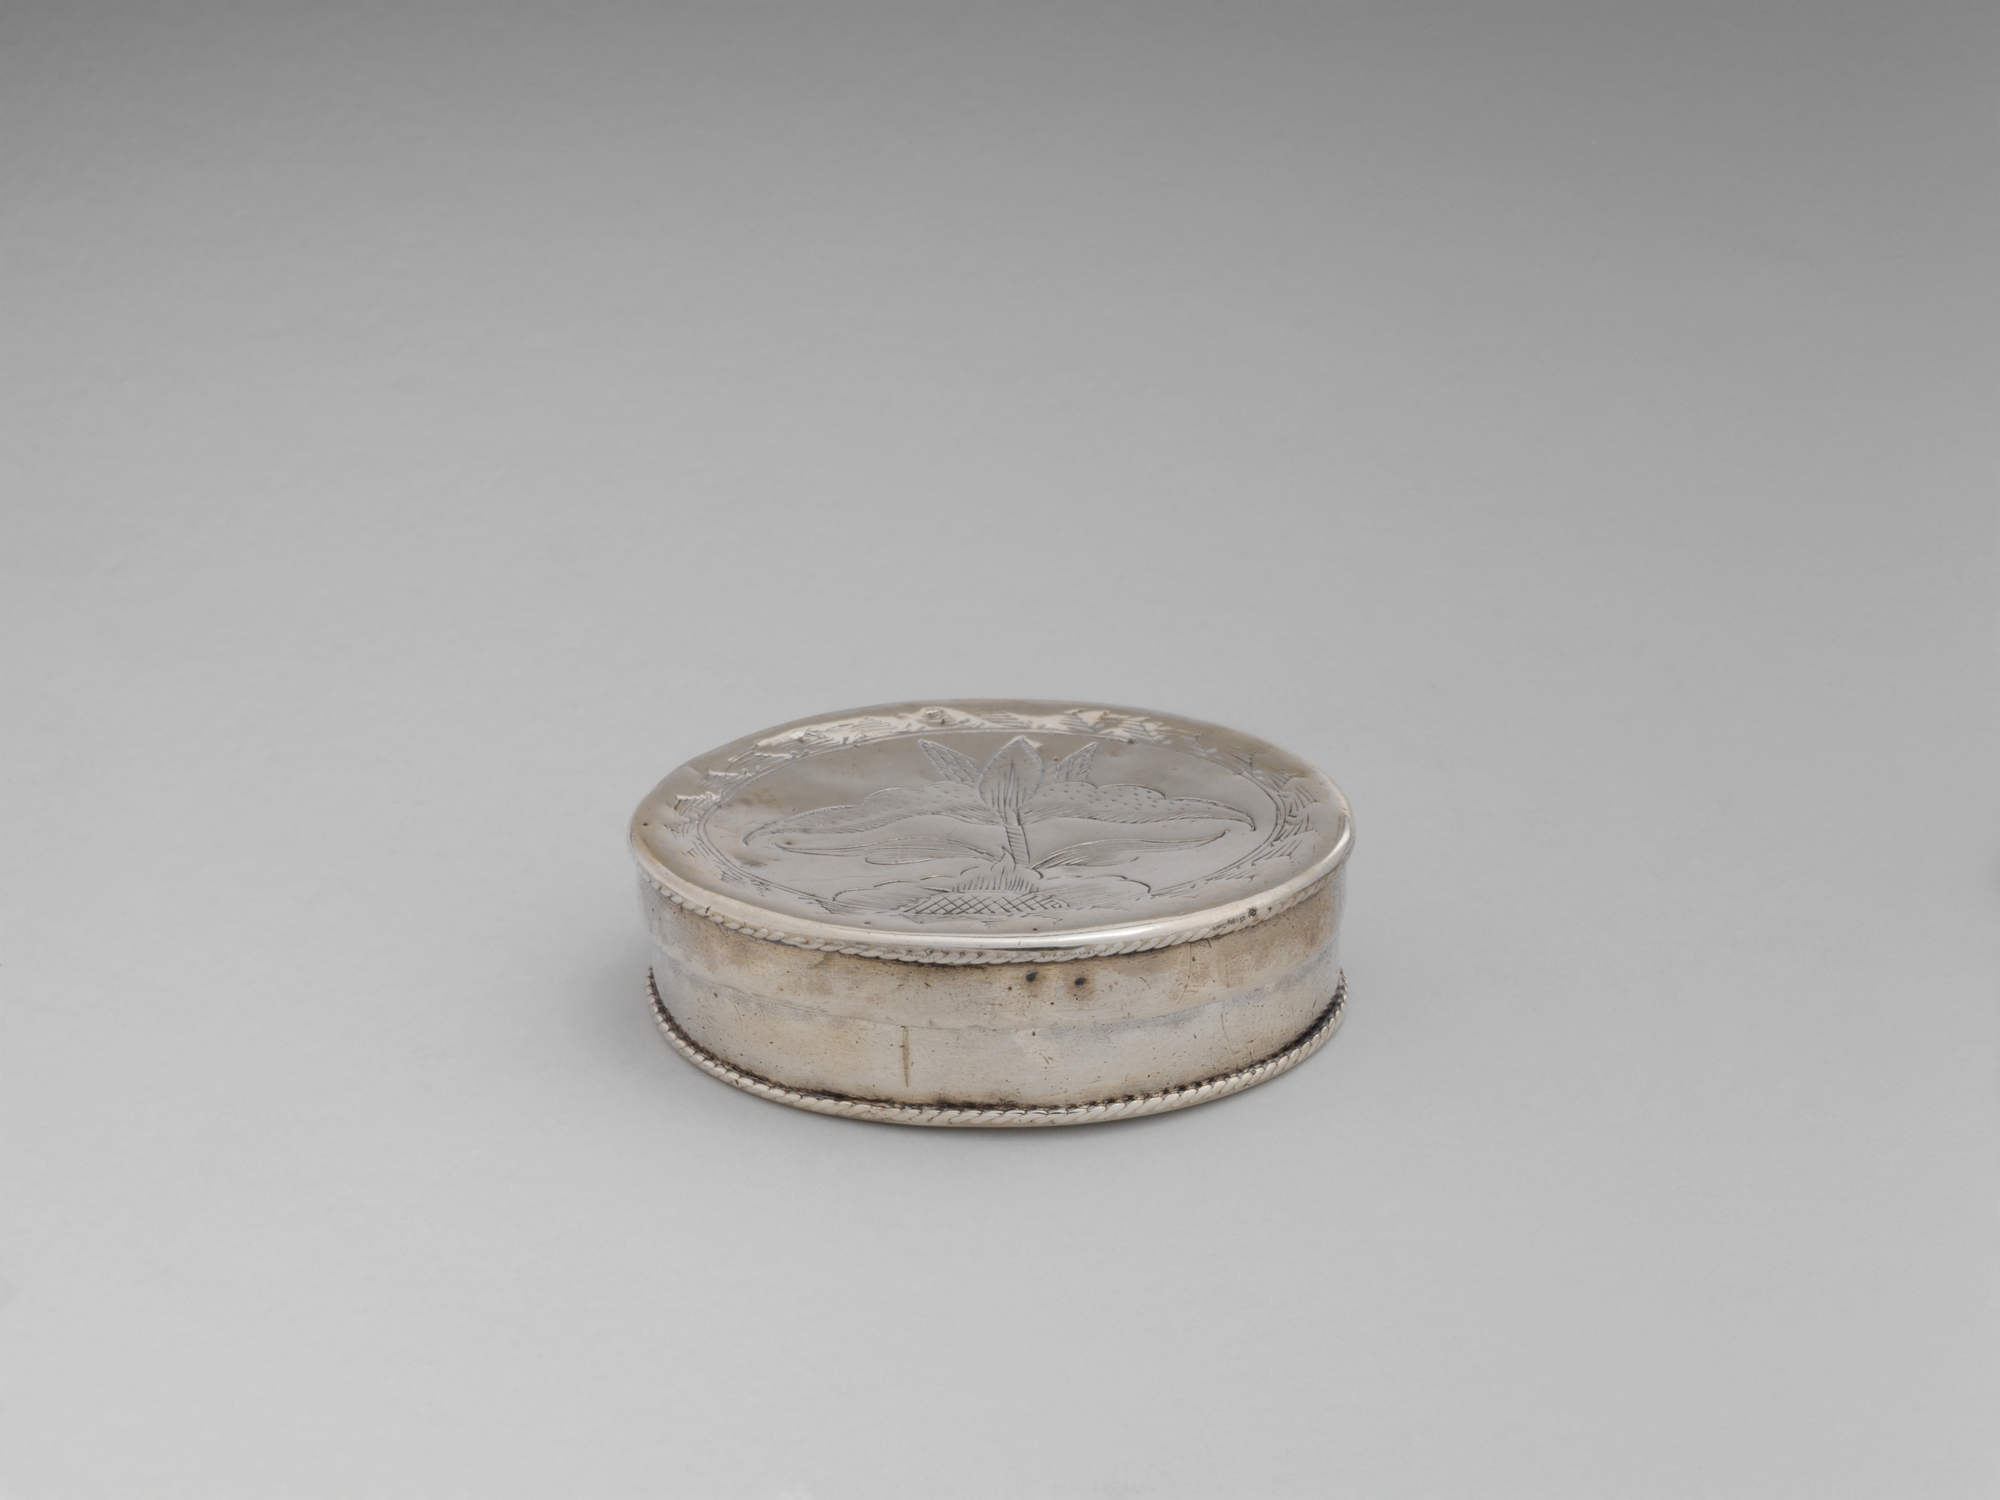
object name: box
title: Patch Box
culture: american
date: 1700-1740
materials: silver